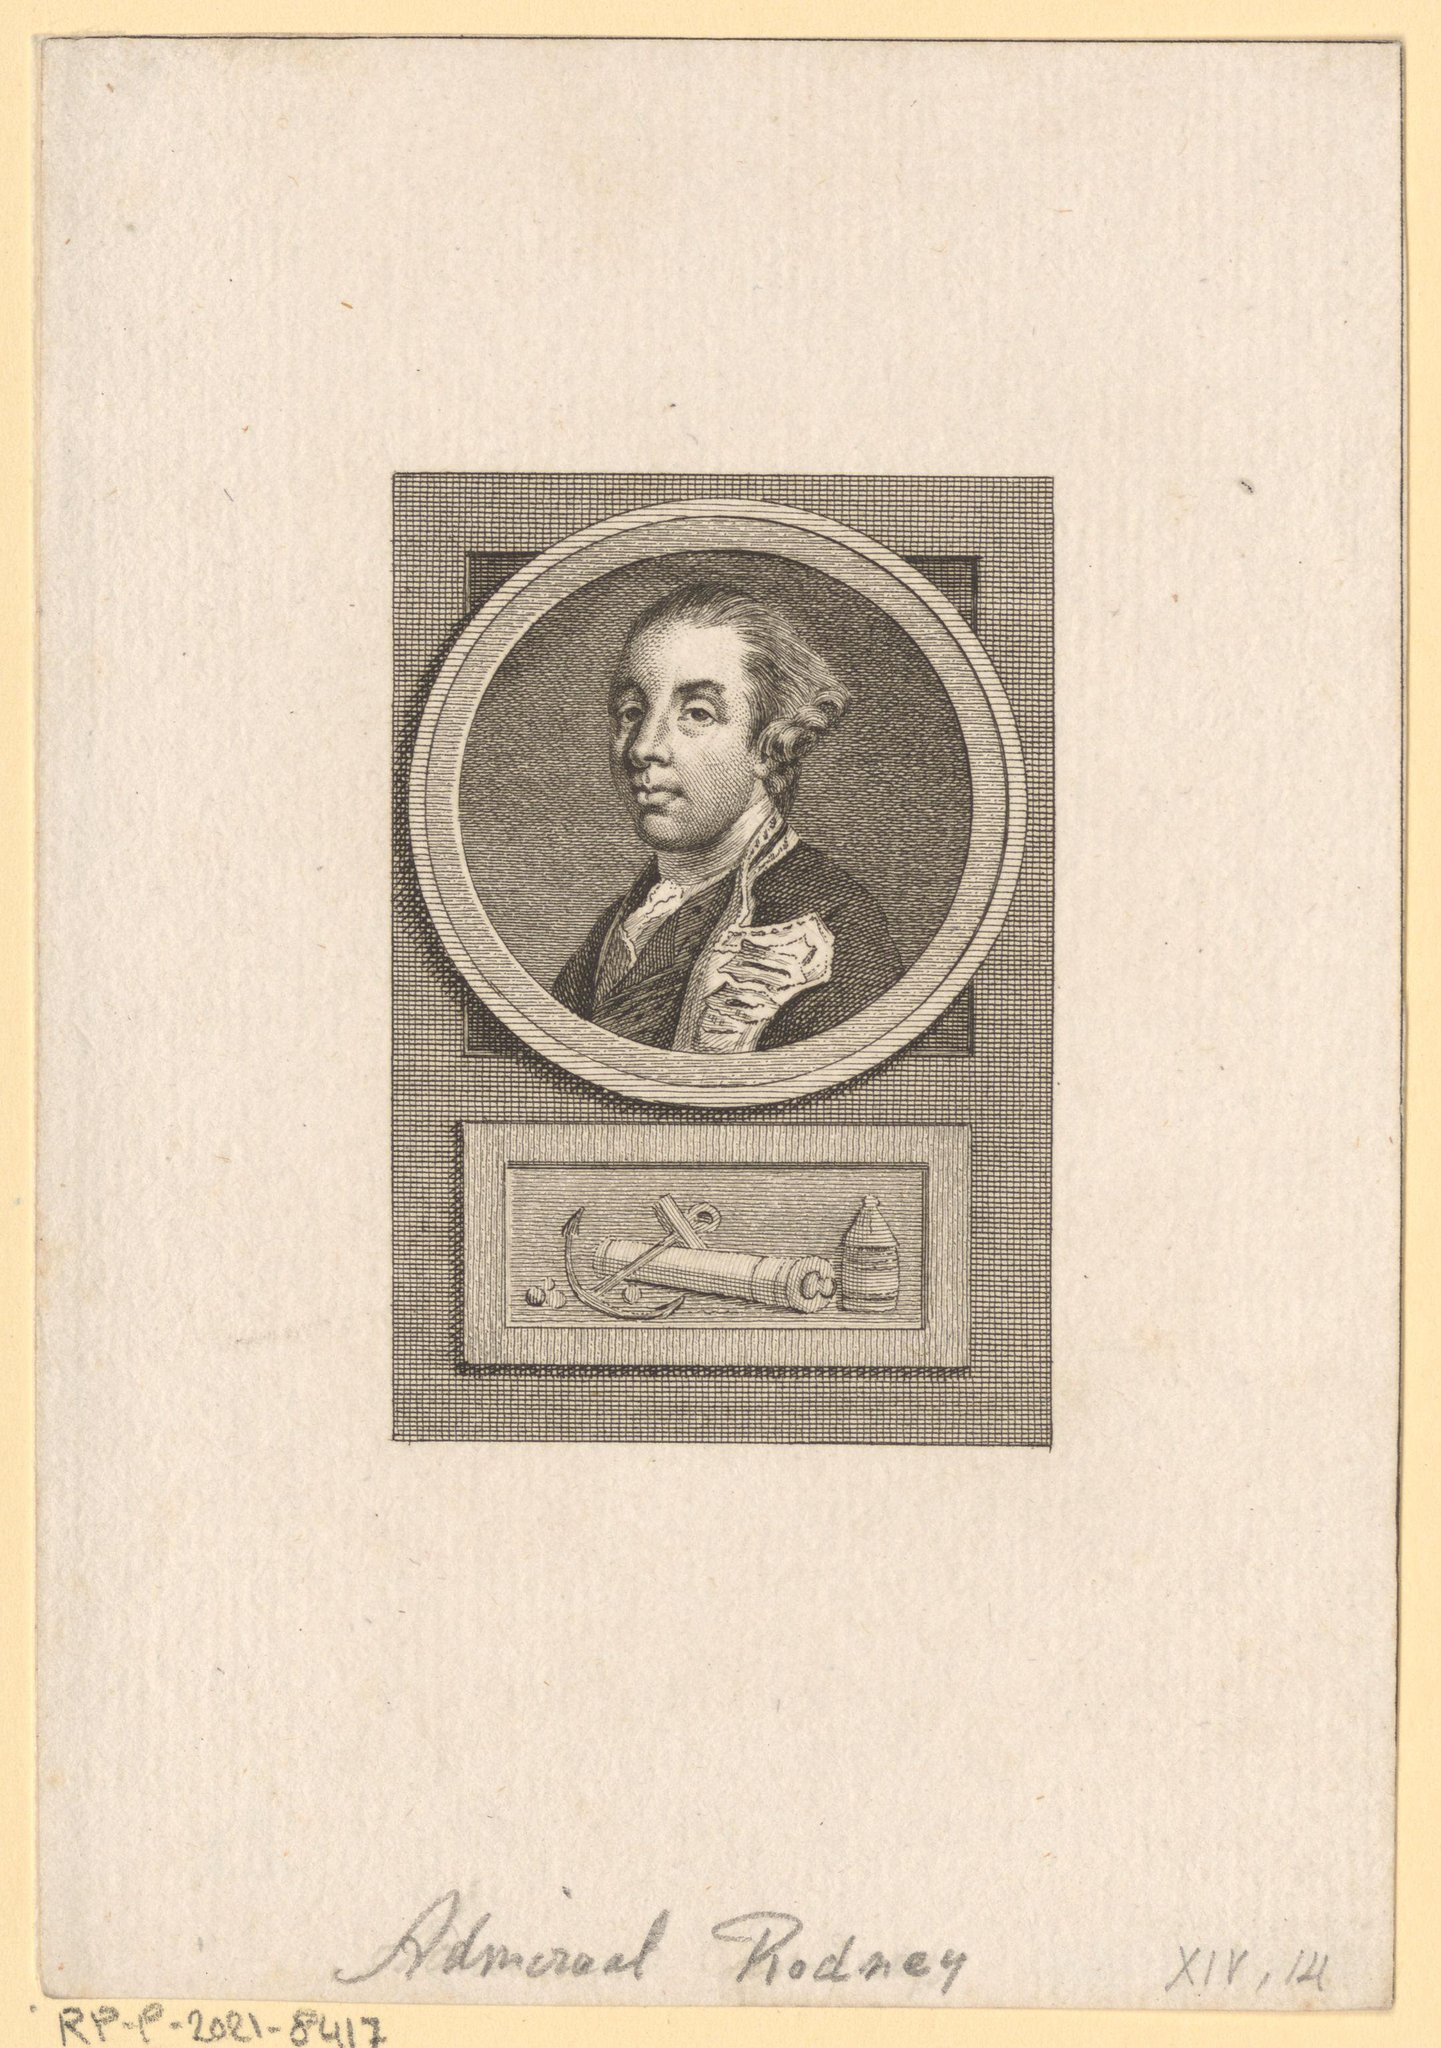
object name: print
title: Portret van baron George Brydges Rodney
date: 1790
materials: paper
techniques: engraving, etching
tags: historical persons, firearms: cannon, parts of ship's exterior: anchor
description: Tweede staat gebruikt in: Kok, Jacobus. Geschiedenissen der Vereenigde Nederlanden. Voor de vaderlandsche jeugd (...). Amsterdam: Johannes Allart, 1790, dl. 14.